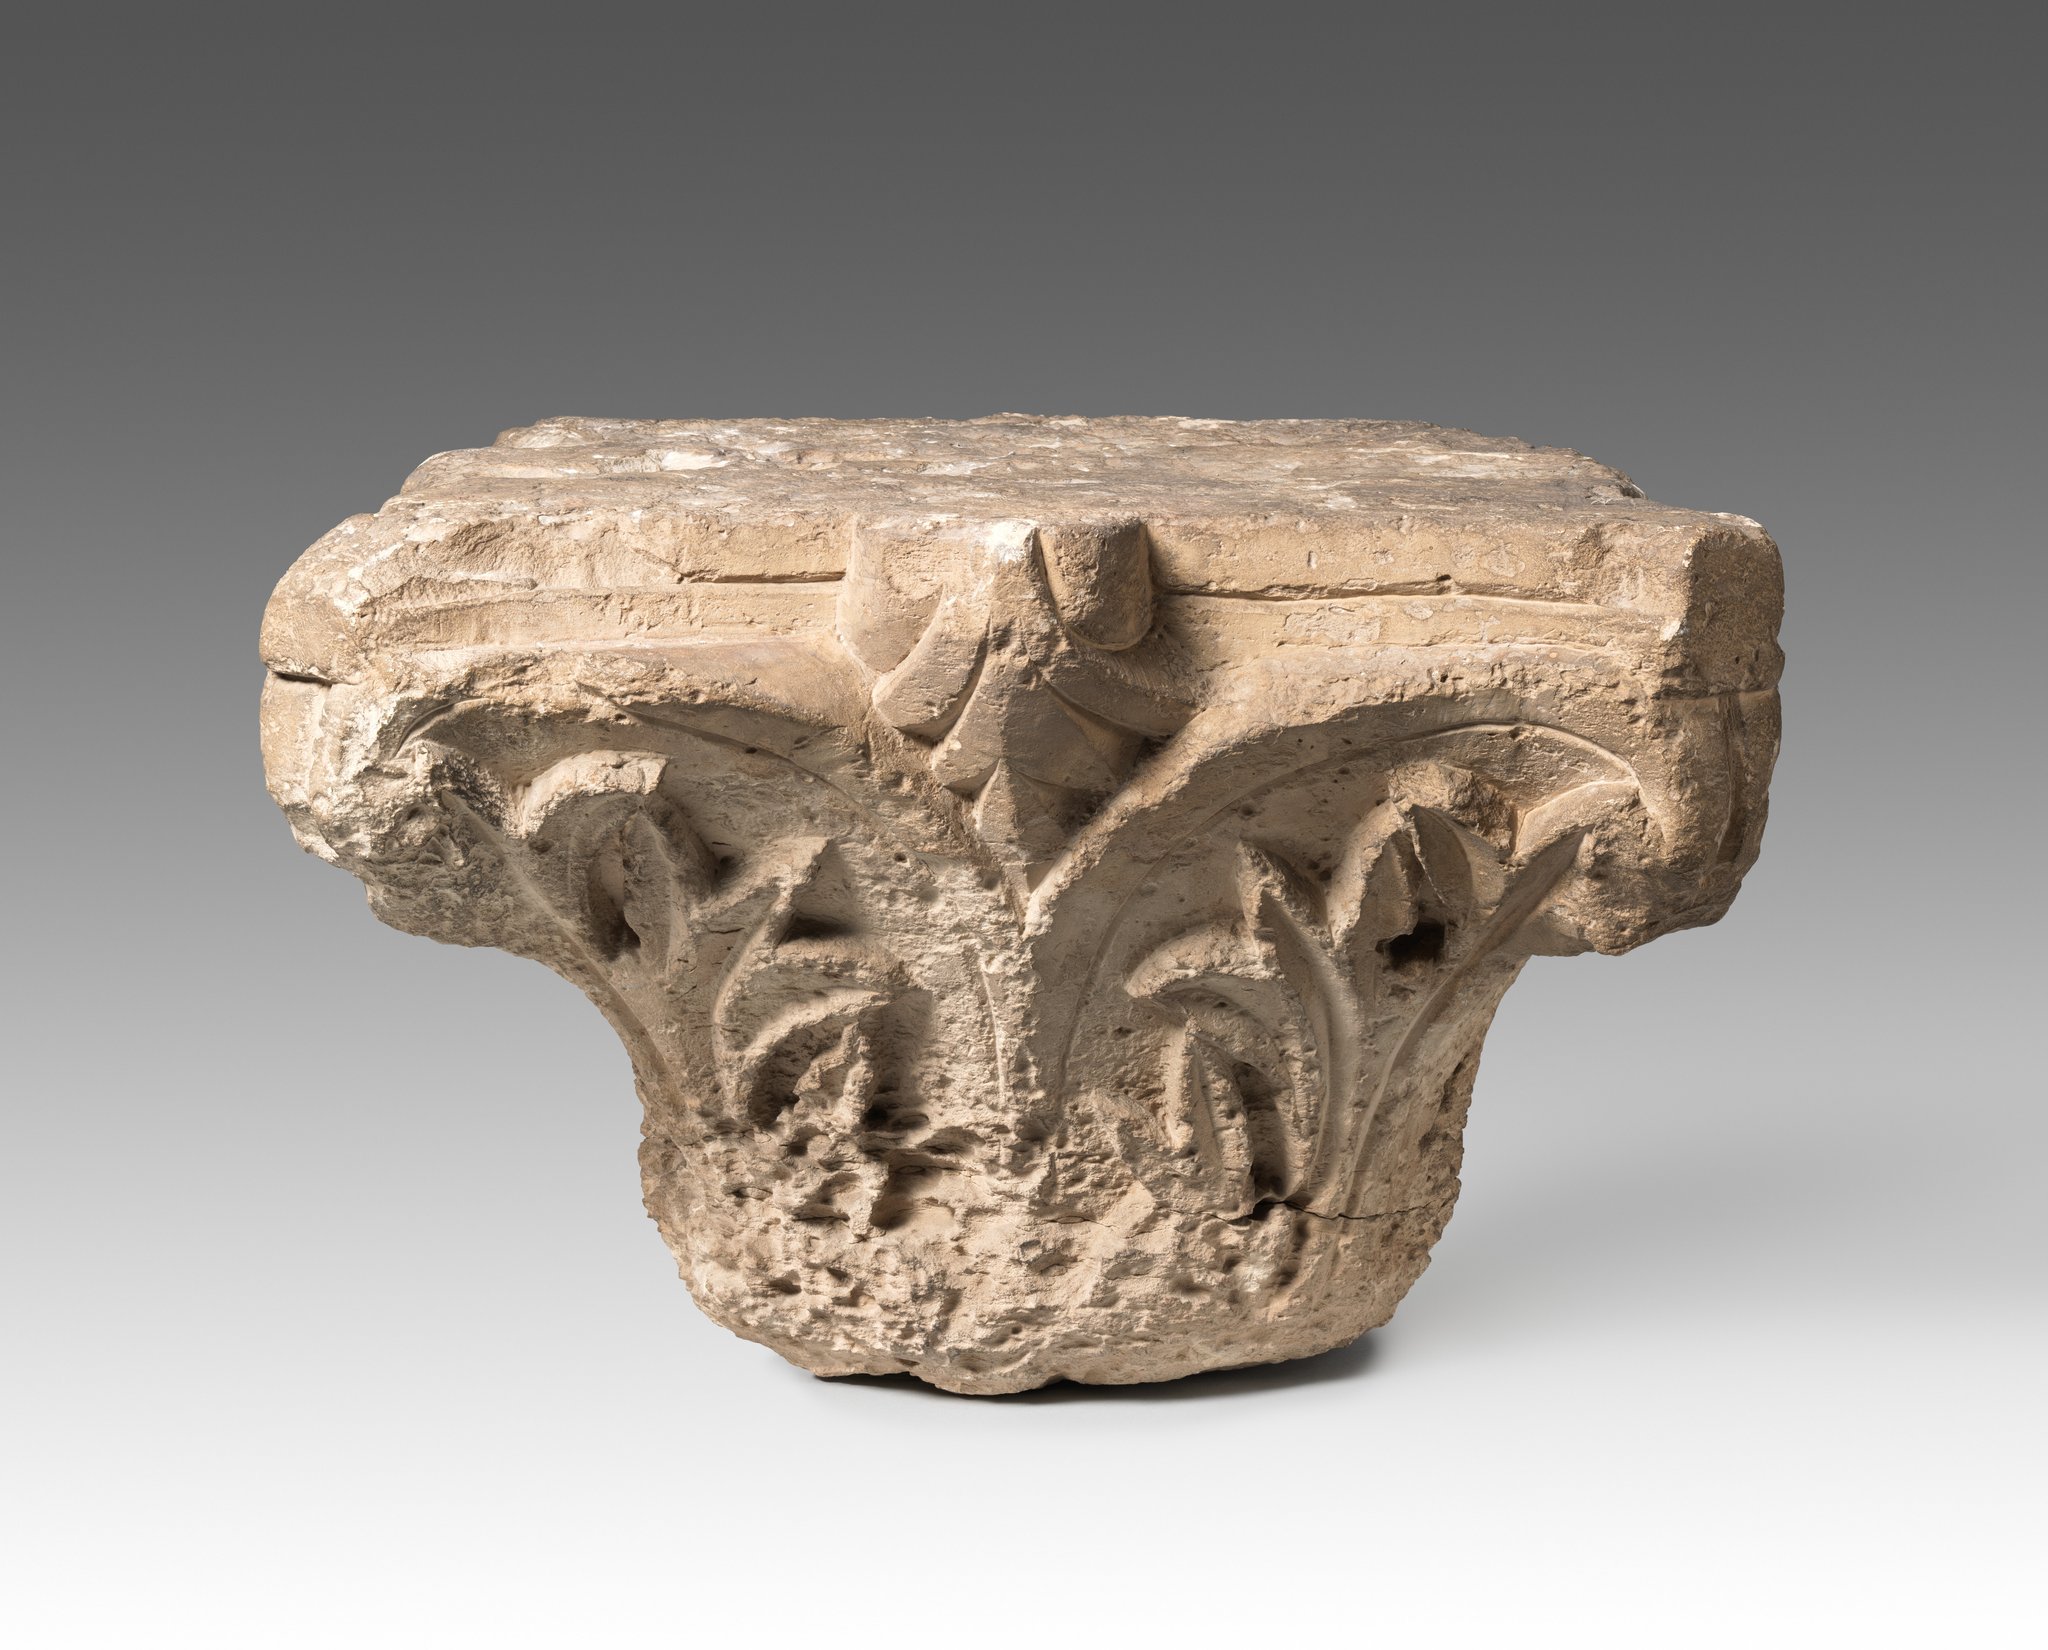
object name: capital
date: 501-700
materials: limestone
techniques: carving, relief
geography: egypt